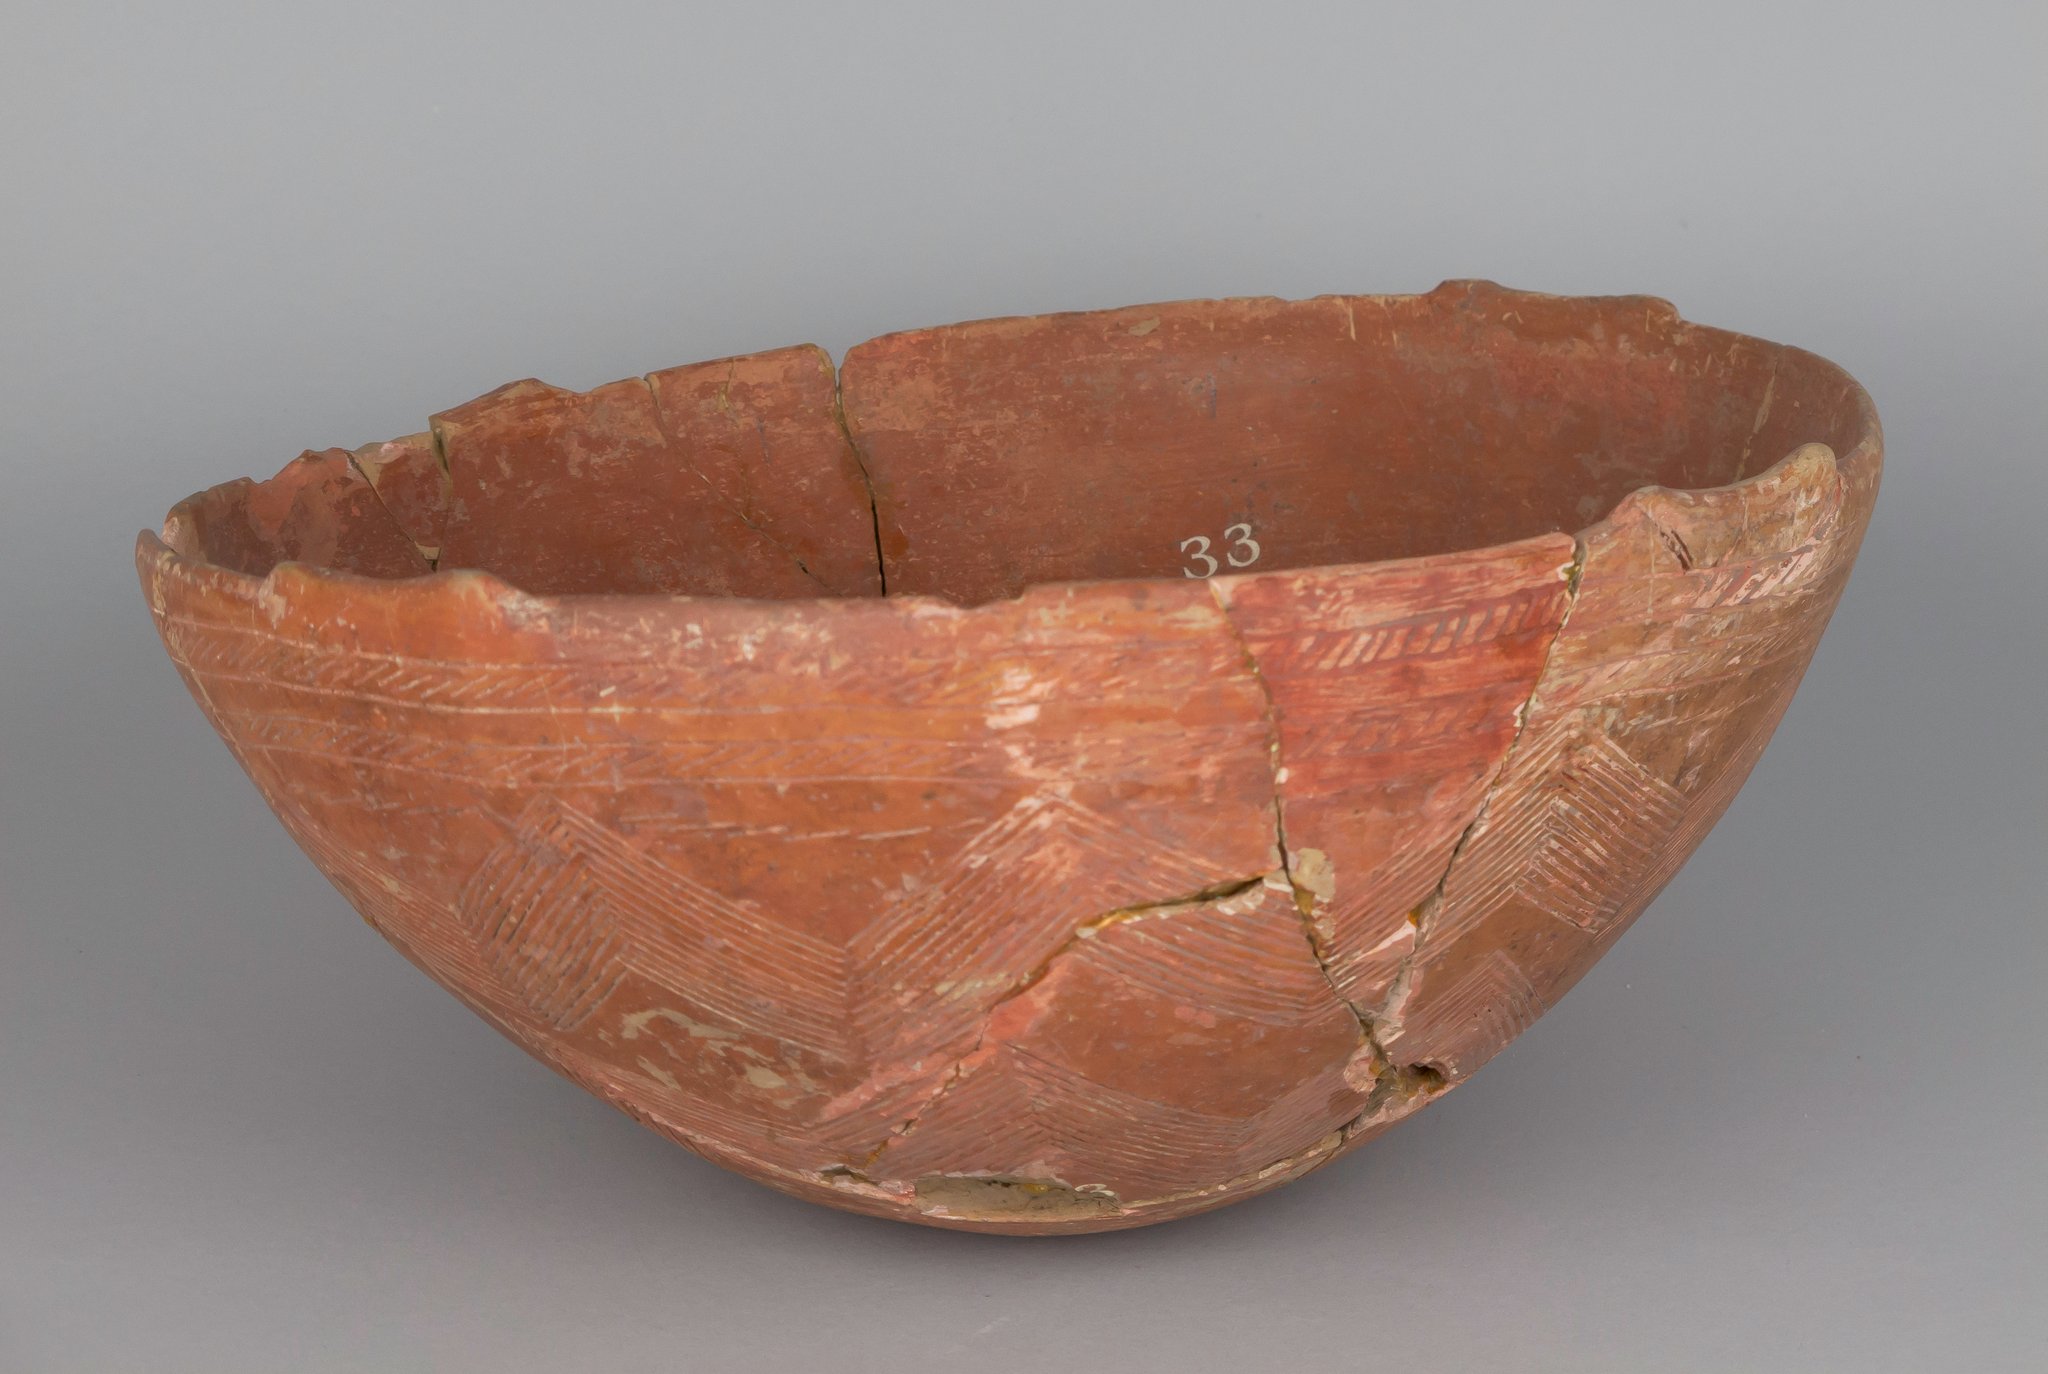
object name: bowl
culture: cypriot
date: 3200-1050 BCE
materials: terracotta